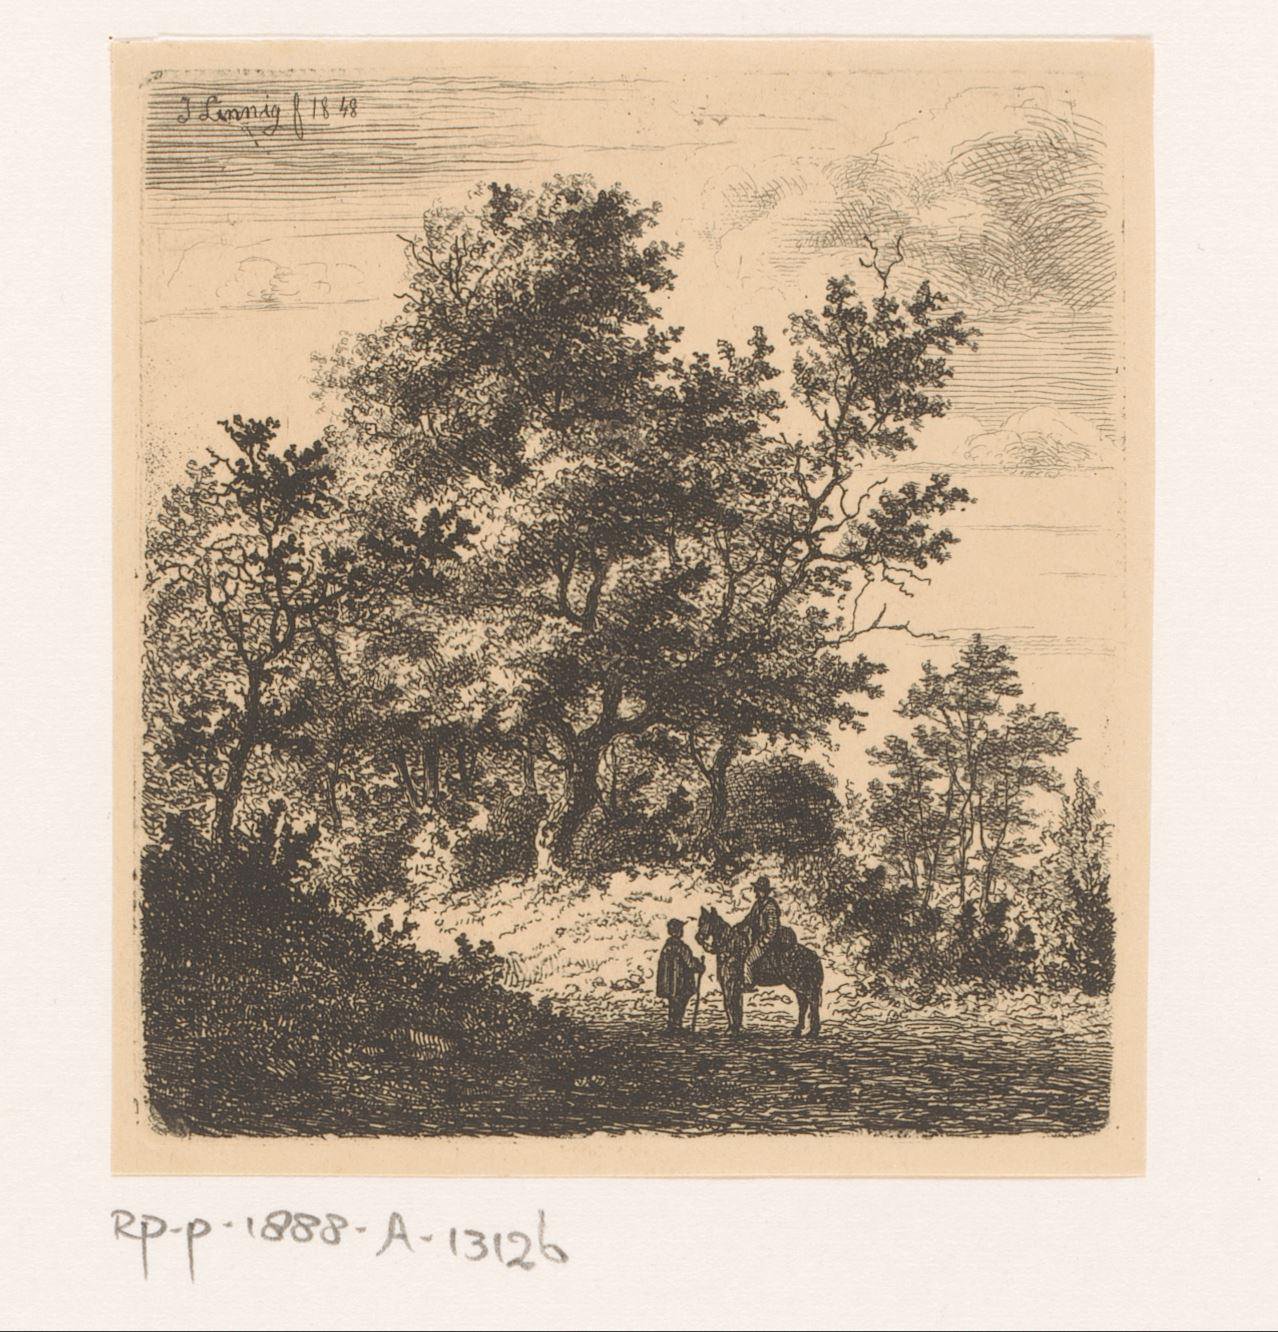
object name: print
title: Boslandschap bij Beert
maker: jean théodore joseph linnig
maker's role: draughtsman, print maker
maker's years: 1815-1891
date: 1848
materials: paper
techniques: etching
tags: forest path or lane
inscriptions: collector's mark: Lugt 2228